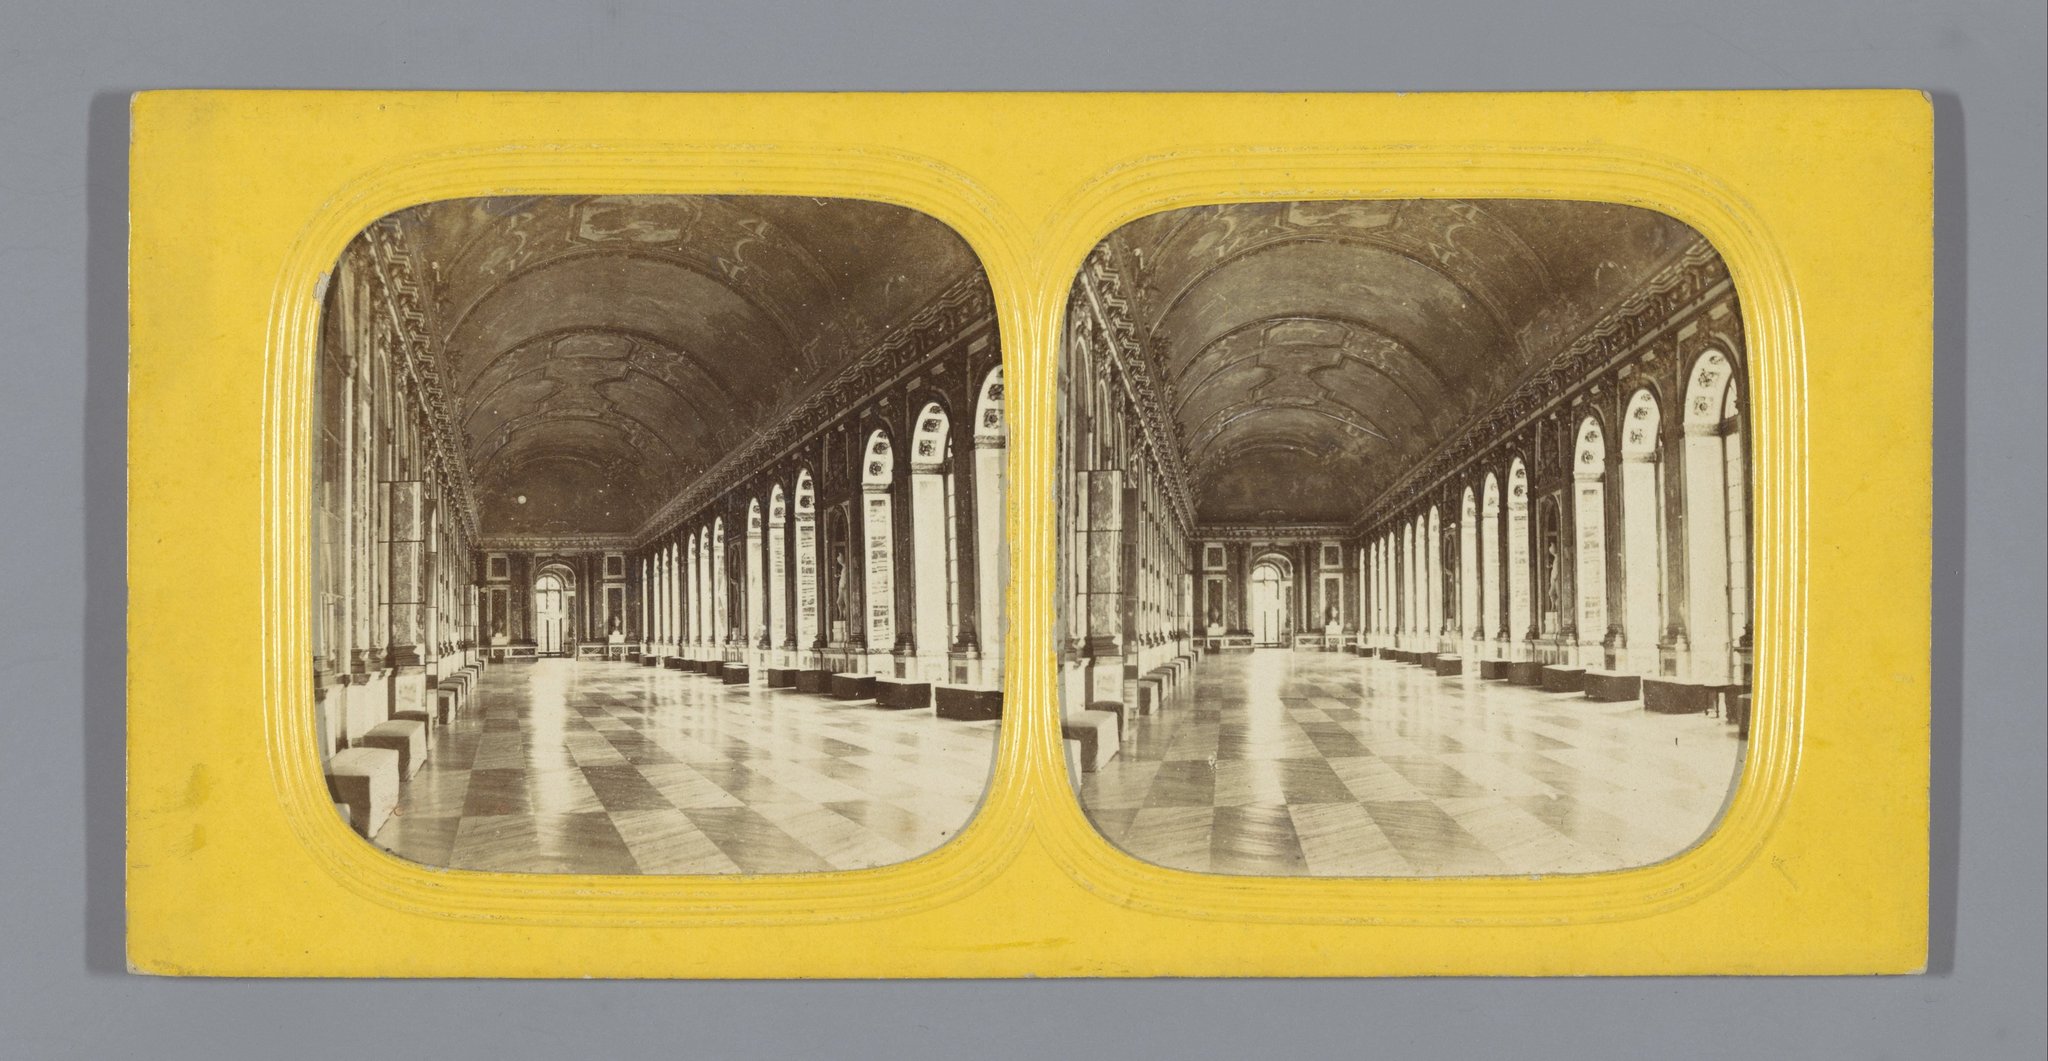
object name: tissue stereograph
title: Salon des Glaces, Versailles, Paris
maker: charles gaudin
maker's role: publisher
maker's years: 1825-1905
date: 1855-1872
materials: cardboard, paper, photographic support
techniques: albumen print, cutting, hand coloring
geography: versailles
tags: gallery (spacious corridor), interior ~ representation of a building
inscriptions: inscription: ‘C.G. PARIS.’